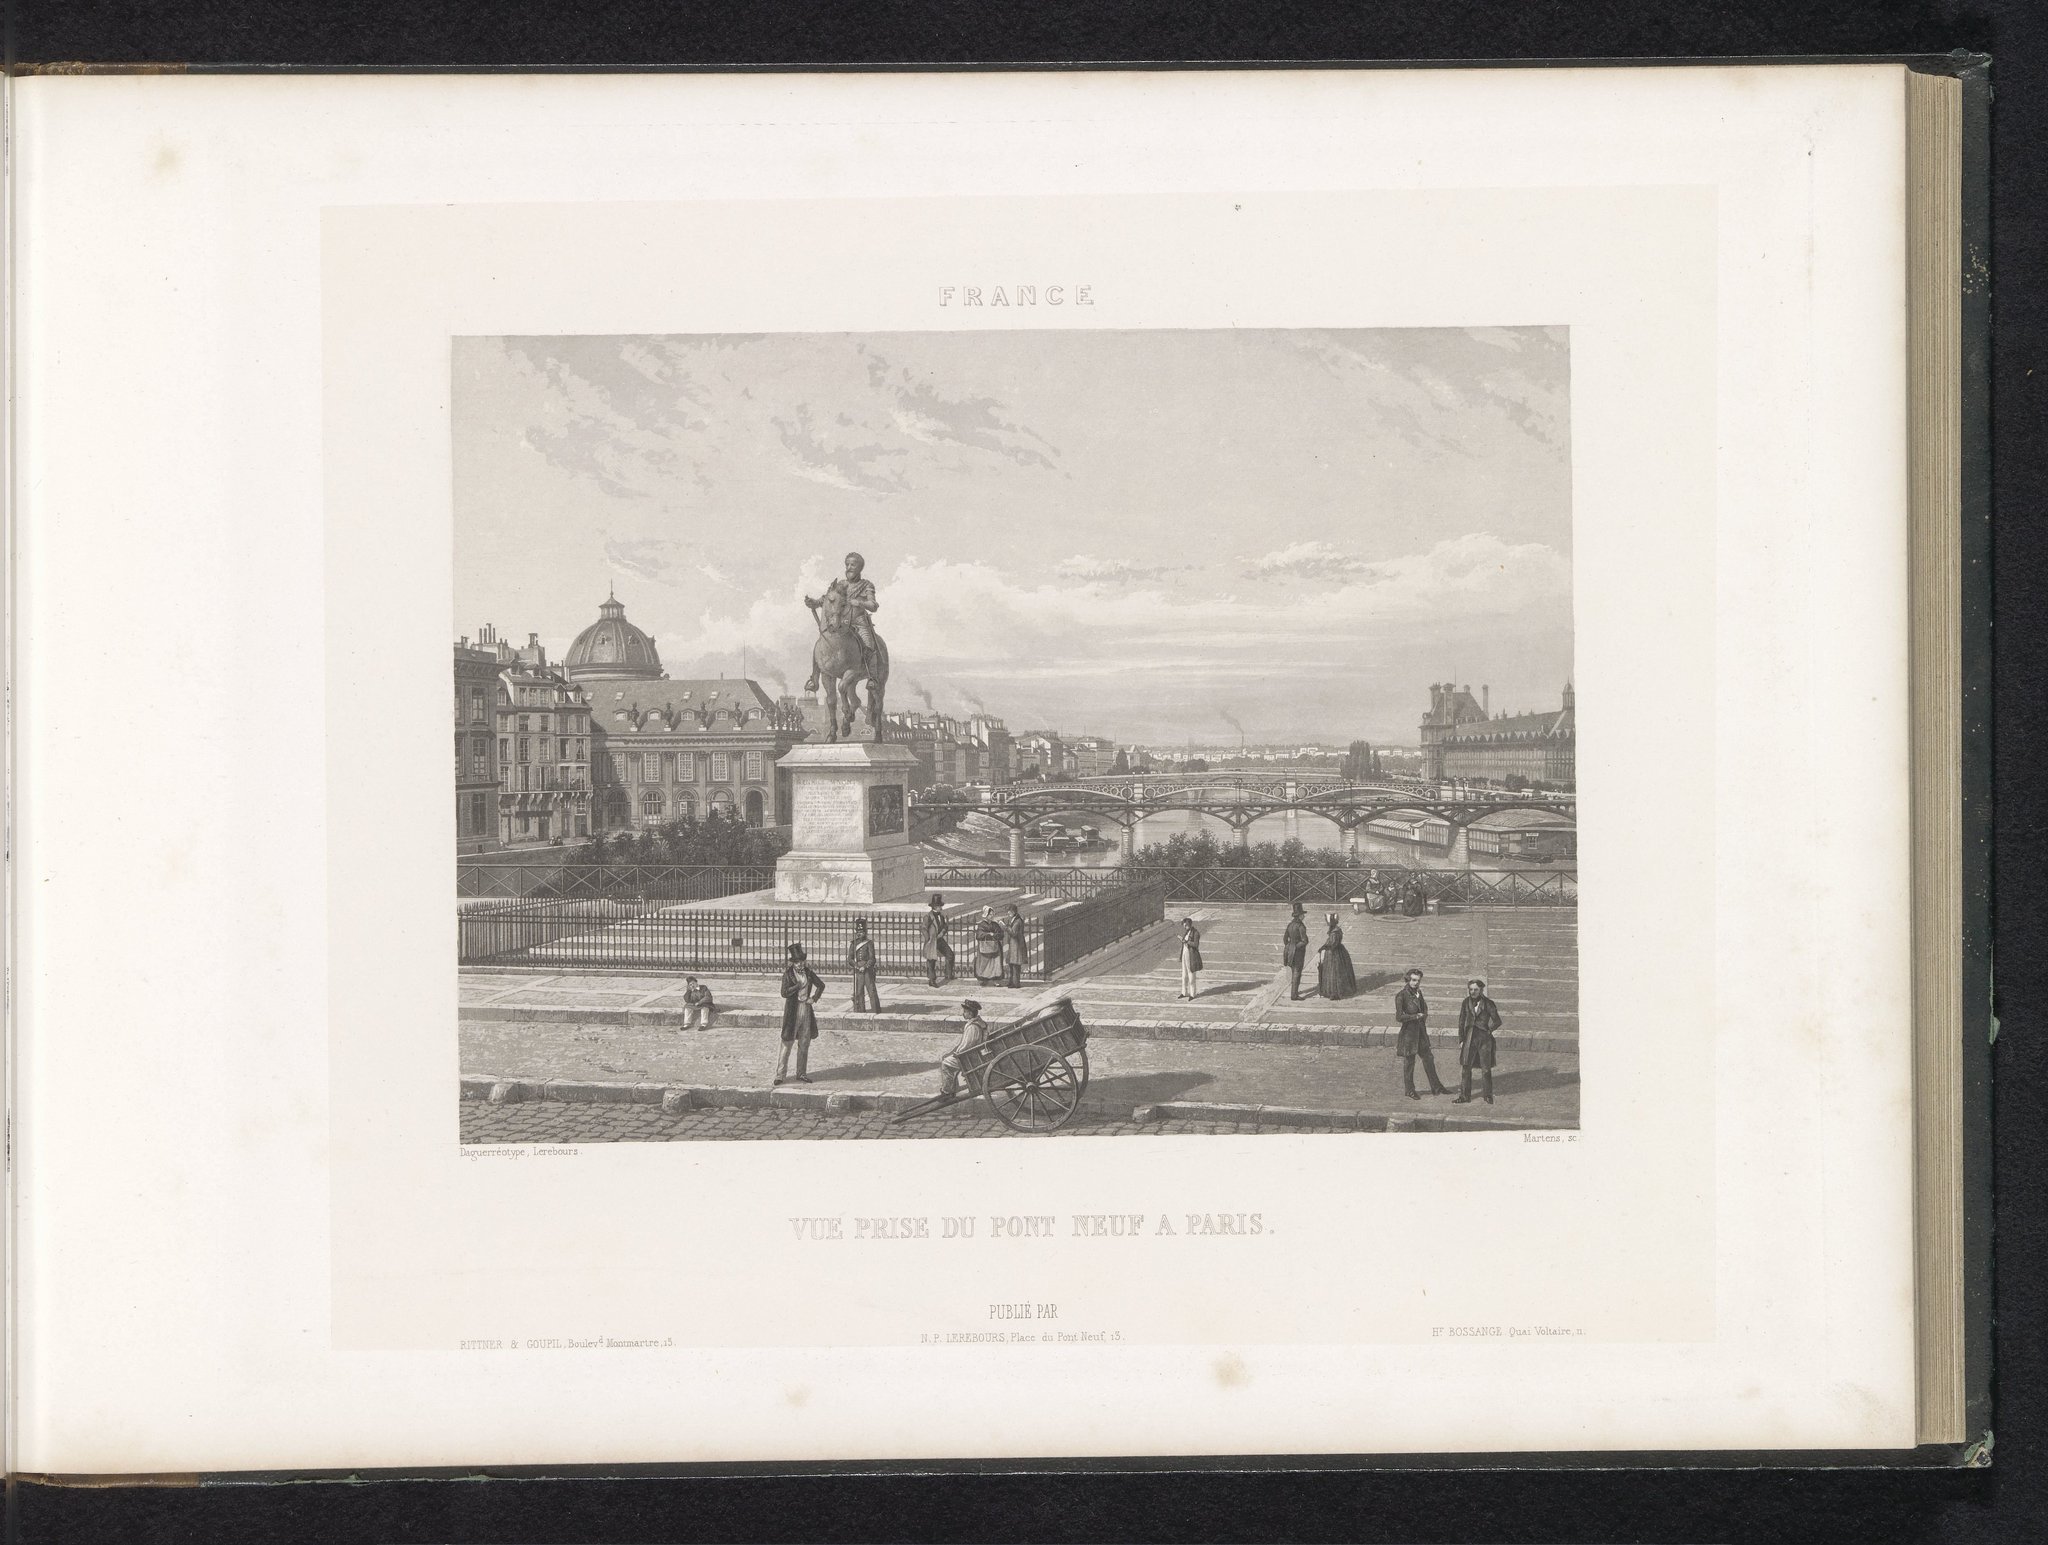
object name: page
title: Vue prise du Pont Neuf a Paris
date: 1839-1841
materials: paper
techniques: aquatint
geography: paris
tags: city-view in general; 'veduta', river, sculpture, paris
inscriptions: inscription: ‘Hr. Bossance Quai Voltaire 11’, inscription: ‘Rittner & Goupil Boulevd Montmartre 15’, inscription: ‘N.P. Lerebours Place du Pont Neuf 15’